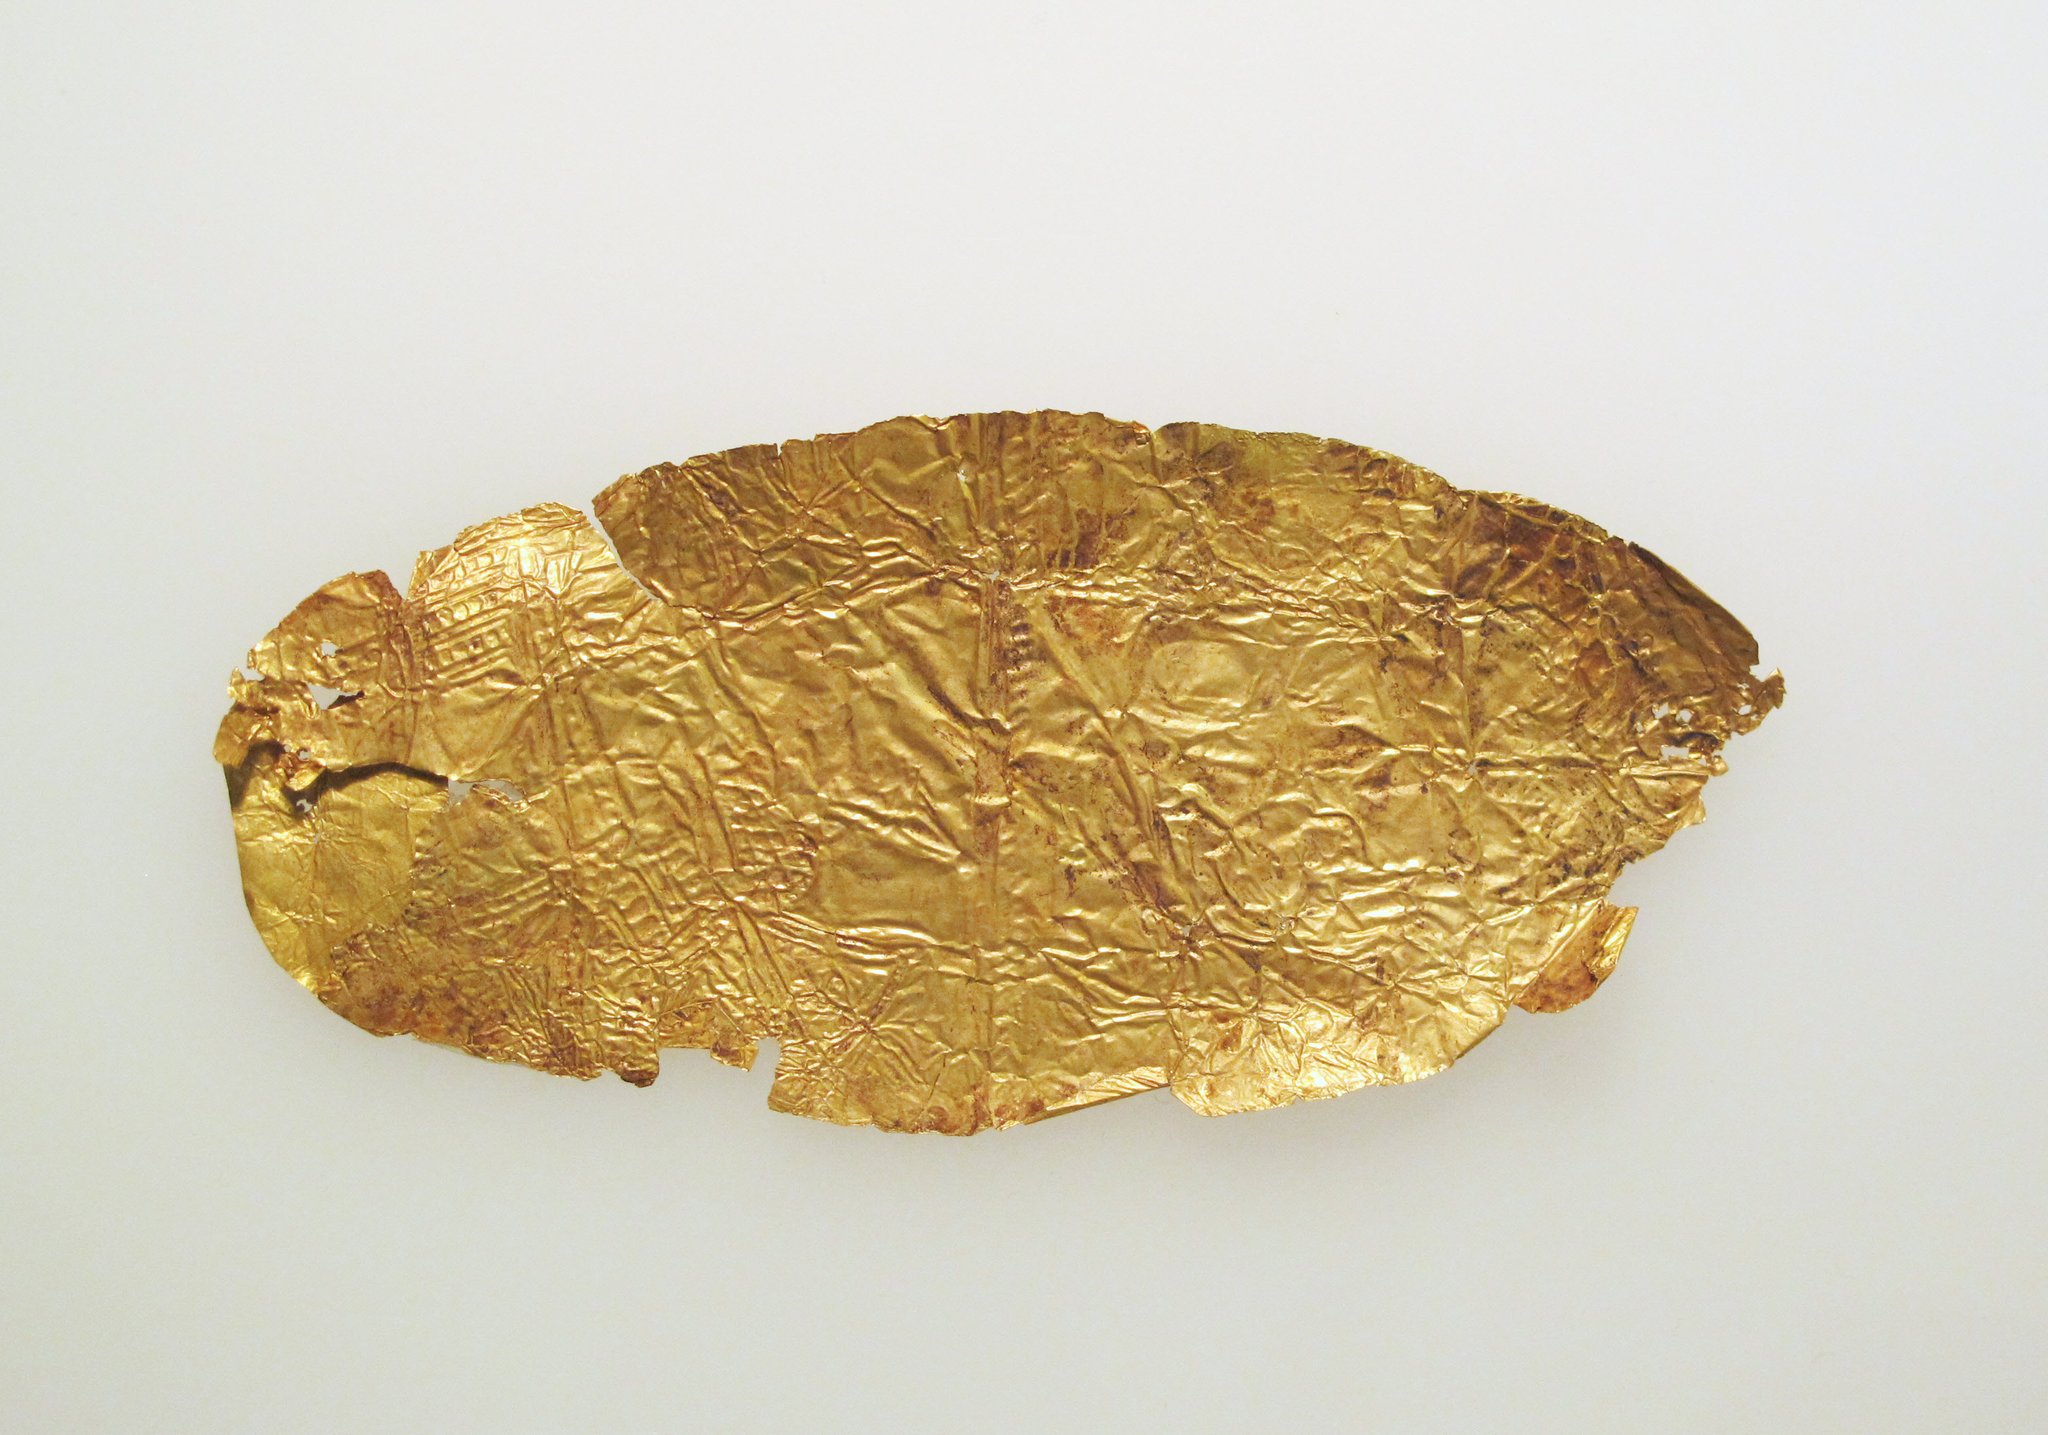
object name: frontlet of gold leaf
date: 7000 BCE-330 CE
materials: gold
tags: leaves